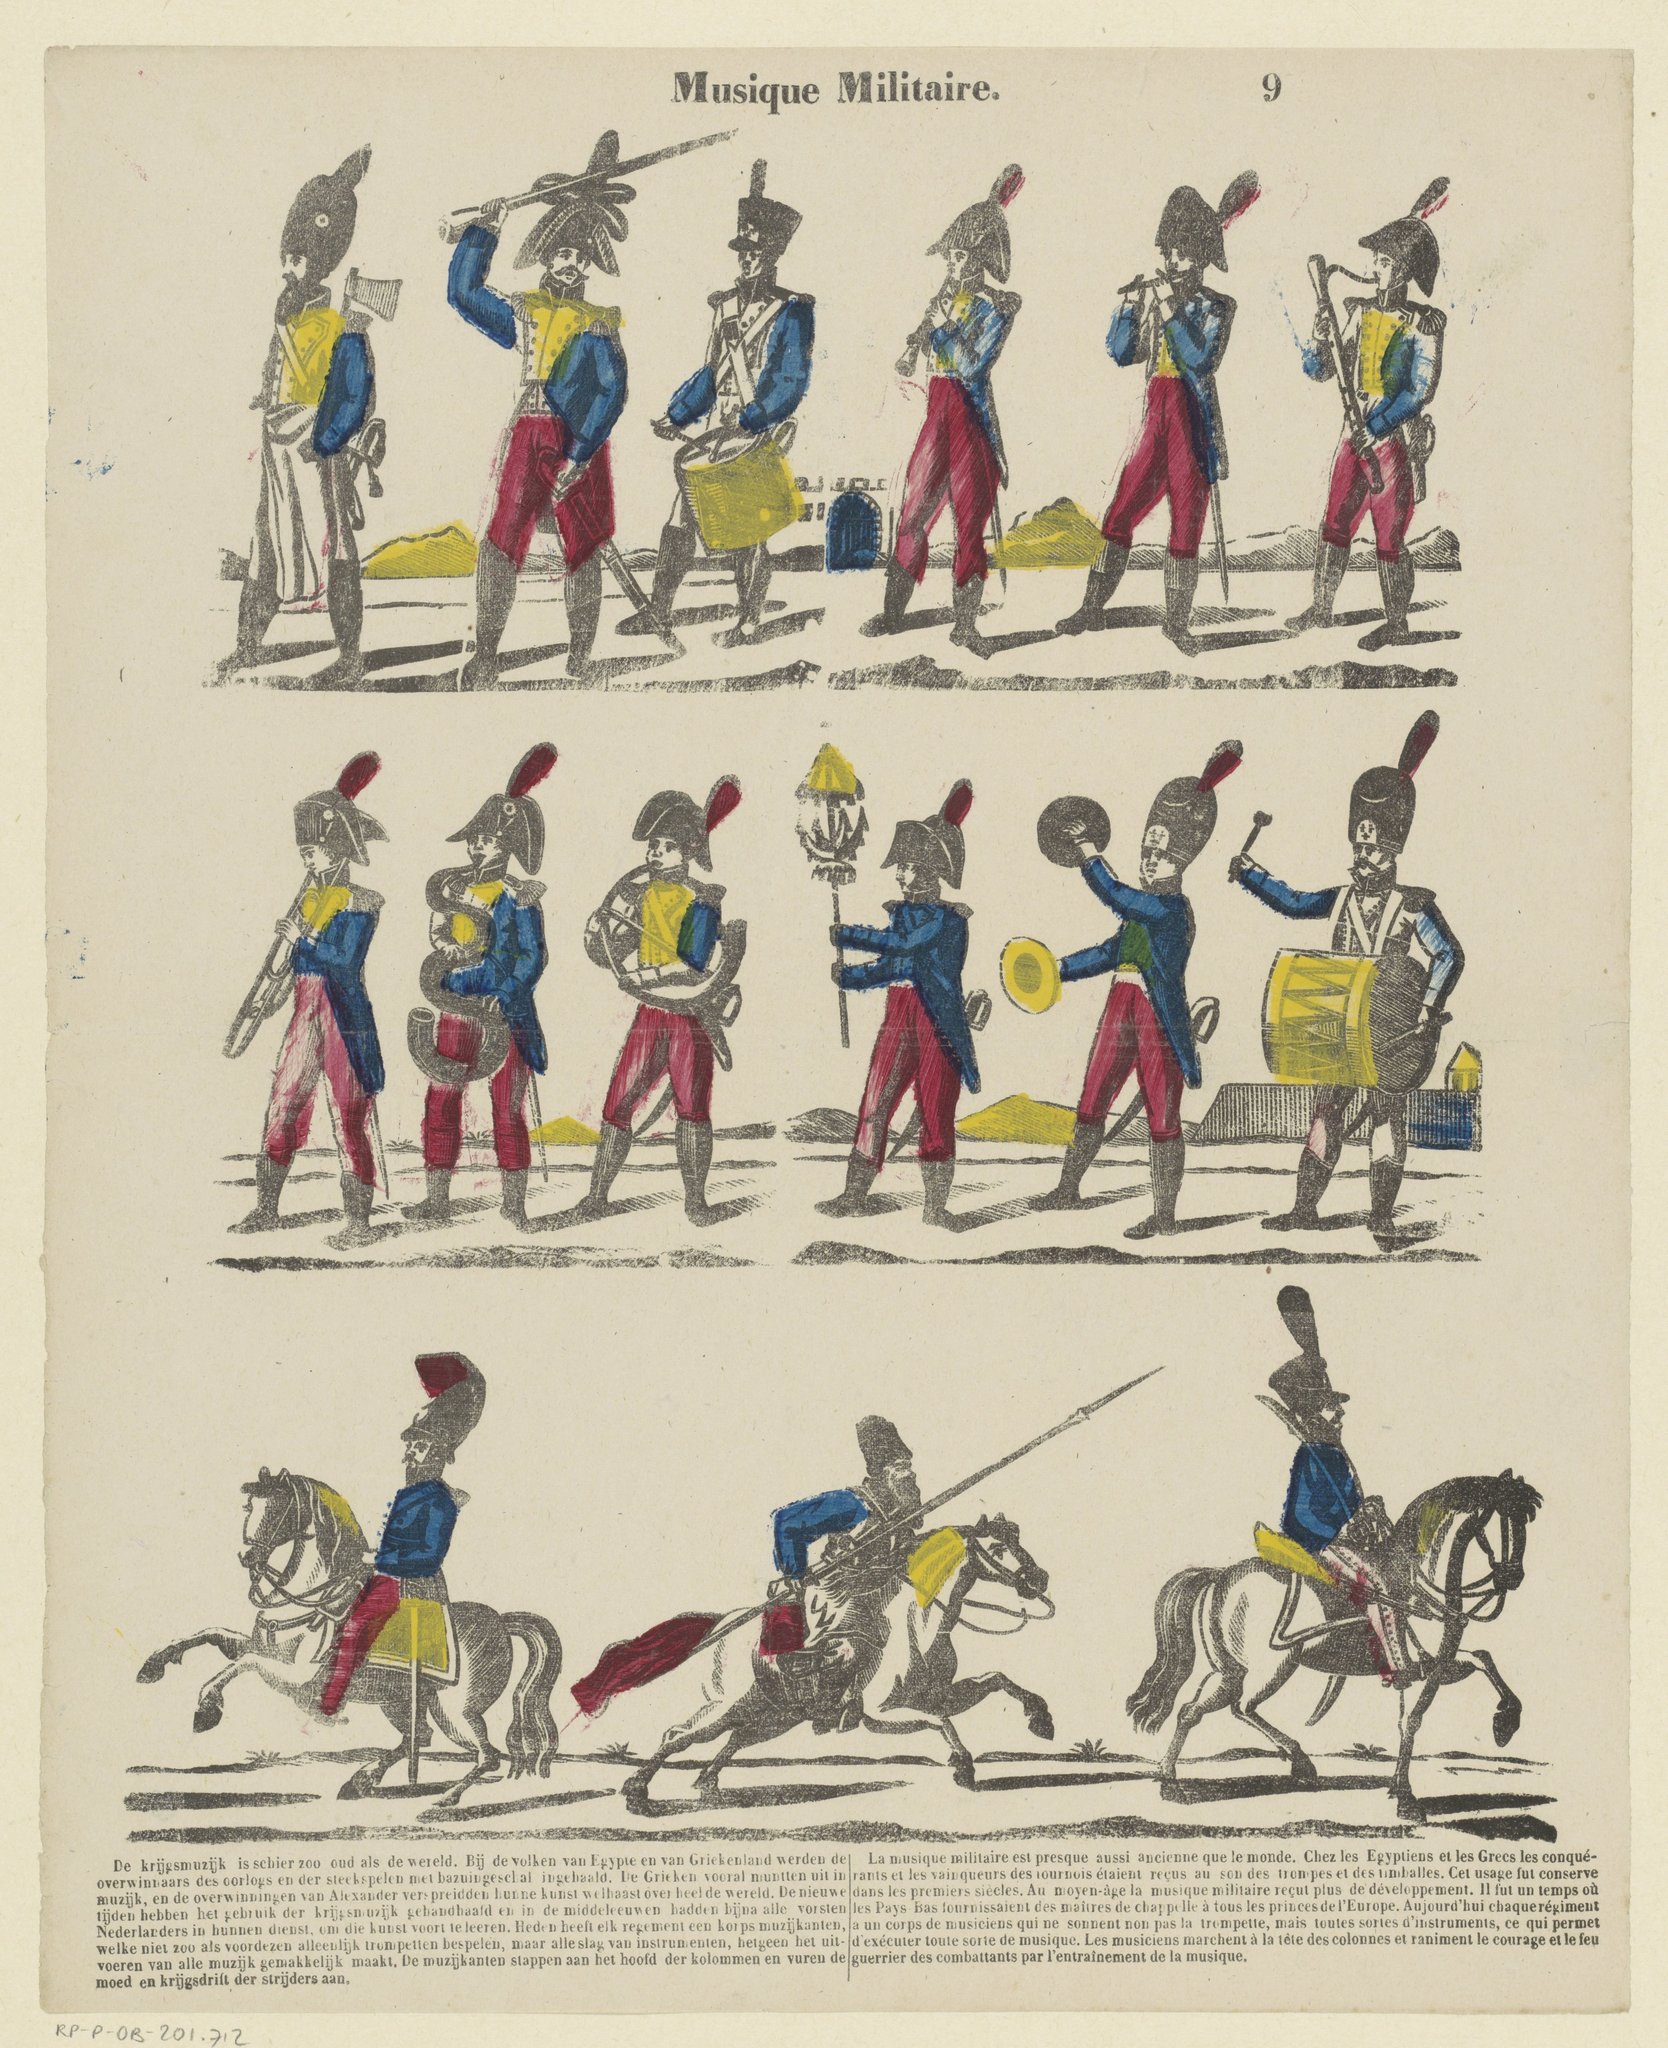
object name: print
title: Musique militaire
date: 1800-1833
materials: paper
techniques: colour, letterpress printing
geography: turnhout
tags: military band, warfare; military affairs (+ cavalry, horsemen), the soldier; the soldier's life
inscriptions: collector's mark: Lugt 2760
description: Blad met 3 horizontale rijen met voorstellingen van militaire muzikanten en militairen te paard. In de ondermarge een achtregelig onderschrift in het Nederlands en in het Frans in twee kolommen. Genummerd rechtsboven: 9.